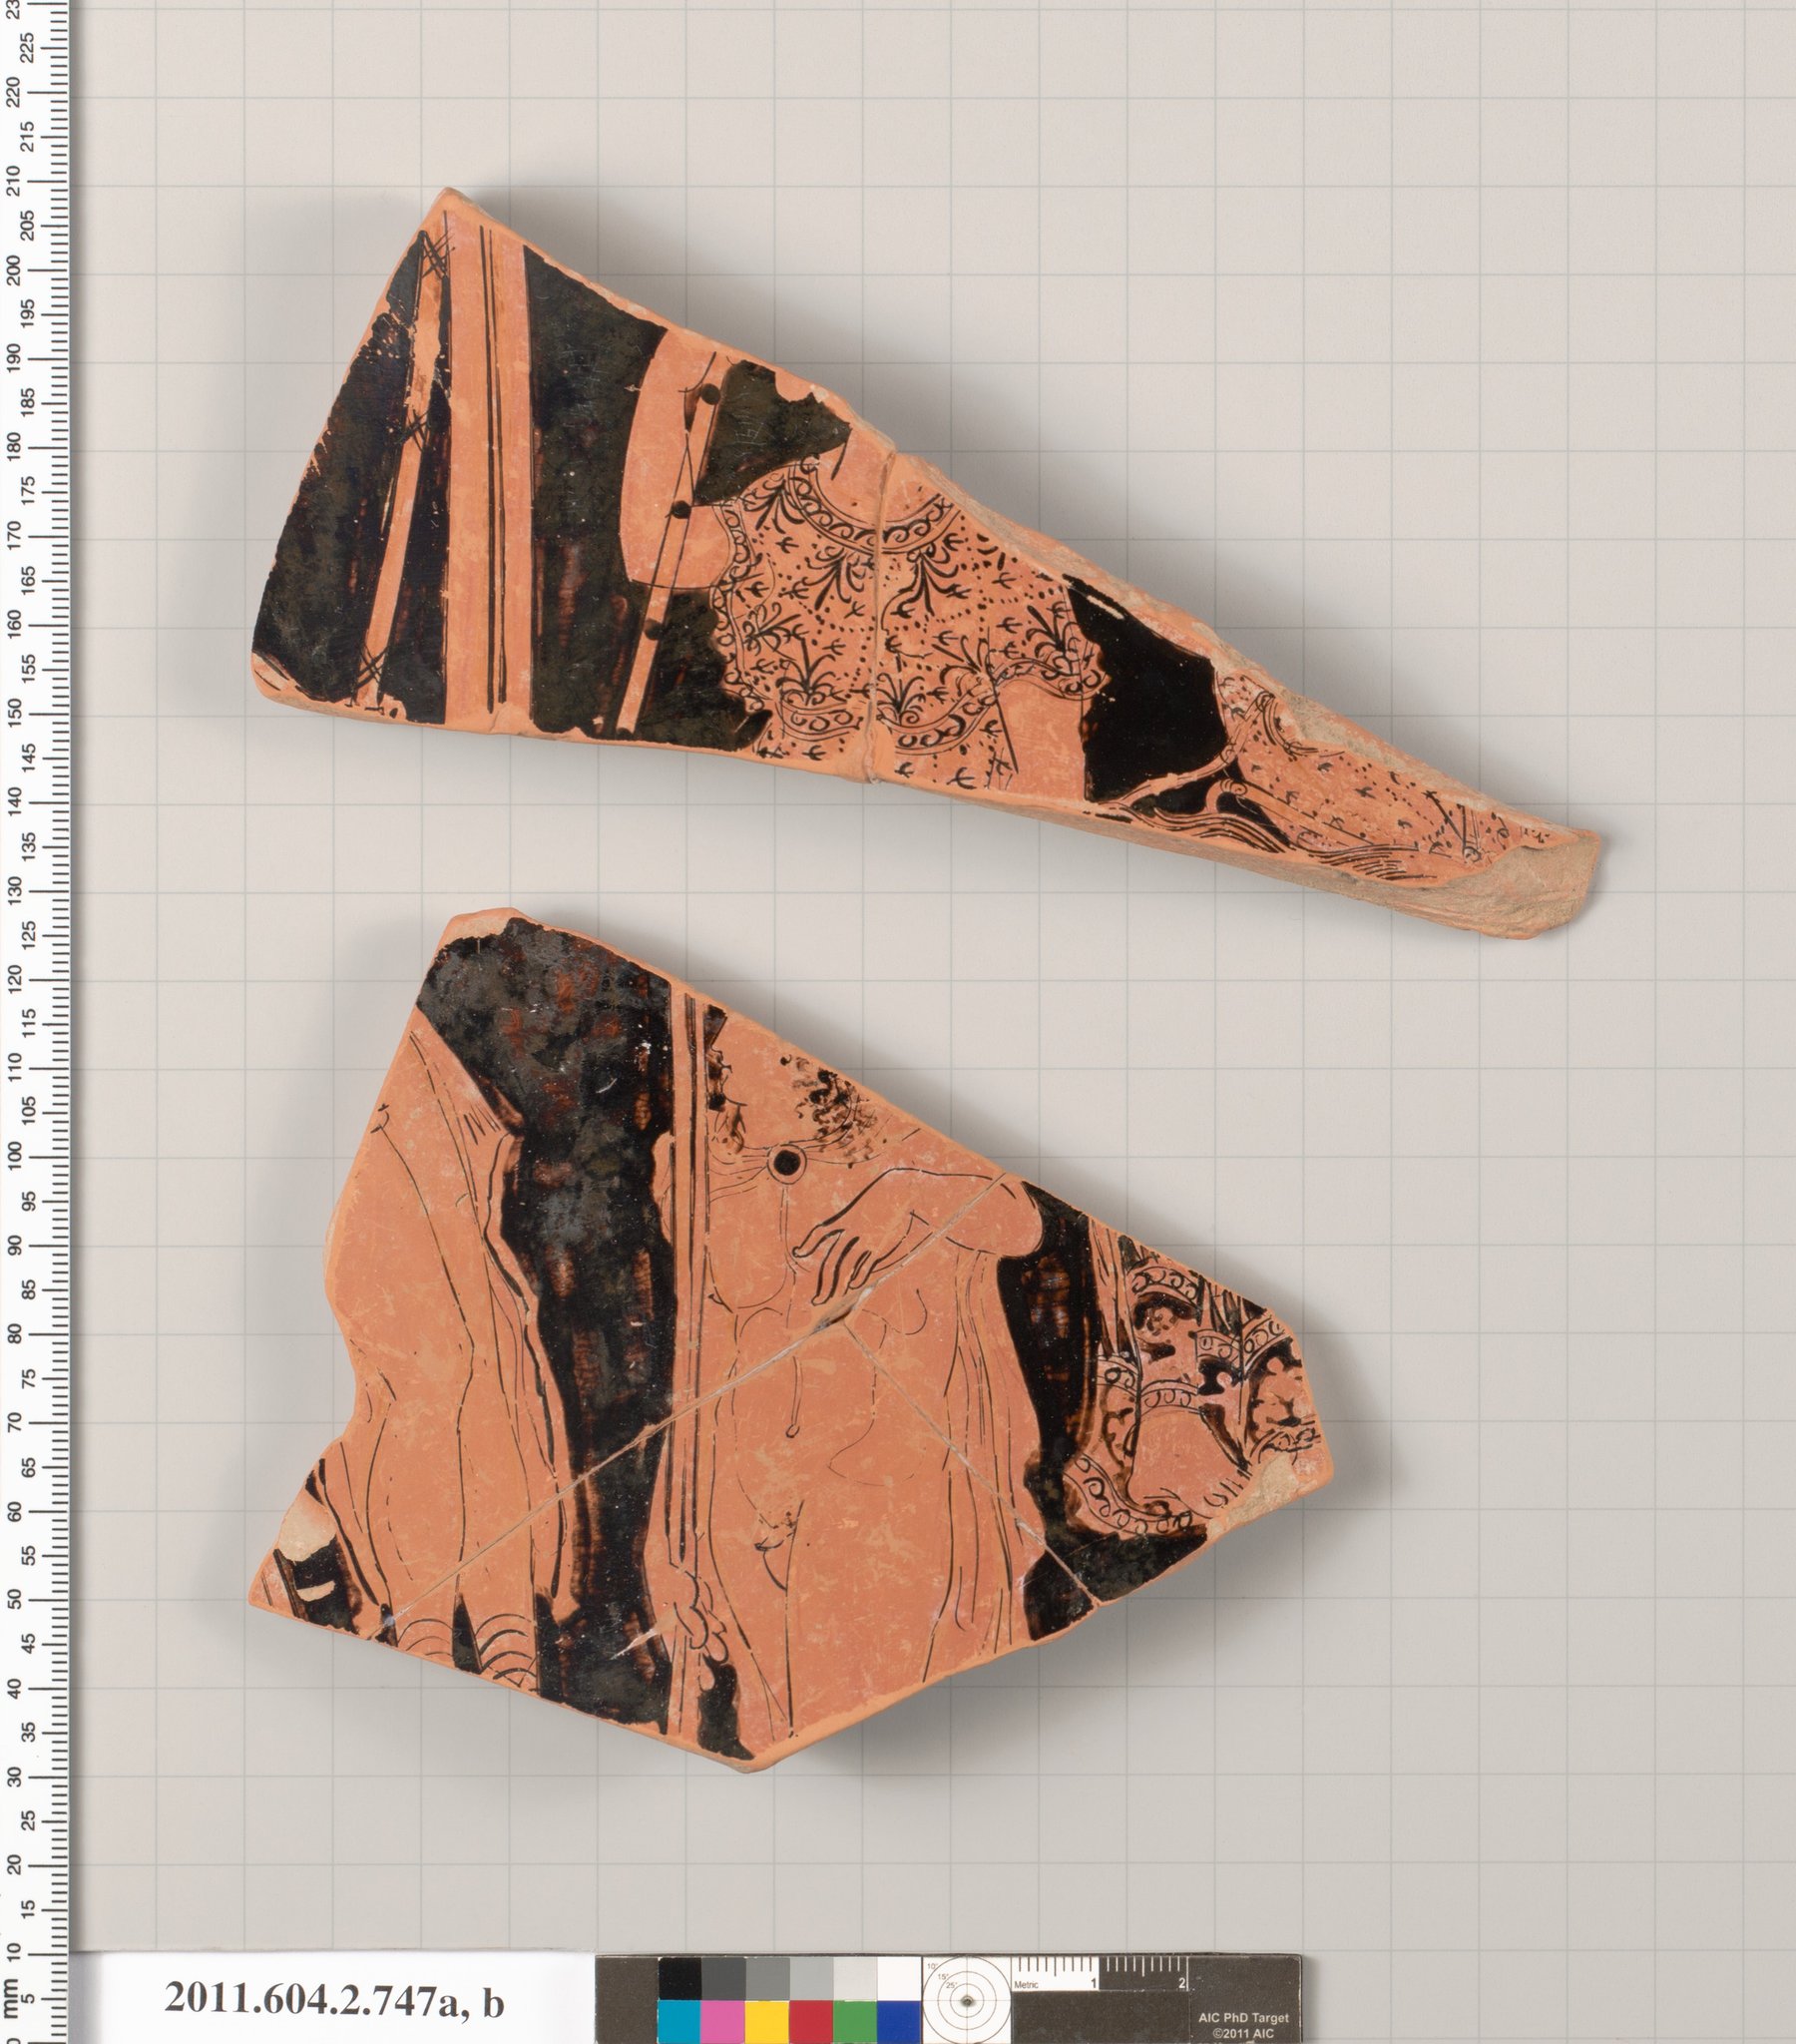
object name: calyx krater fragment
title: Terracotta fragment of a calyx-krater (bowl for mixing wine and water)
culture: greek, attic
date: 440-425 BCE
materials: terracotta